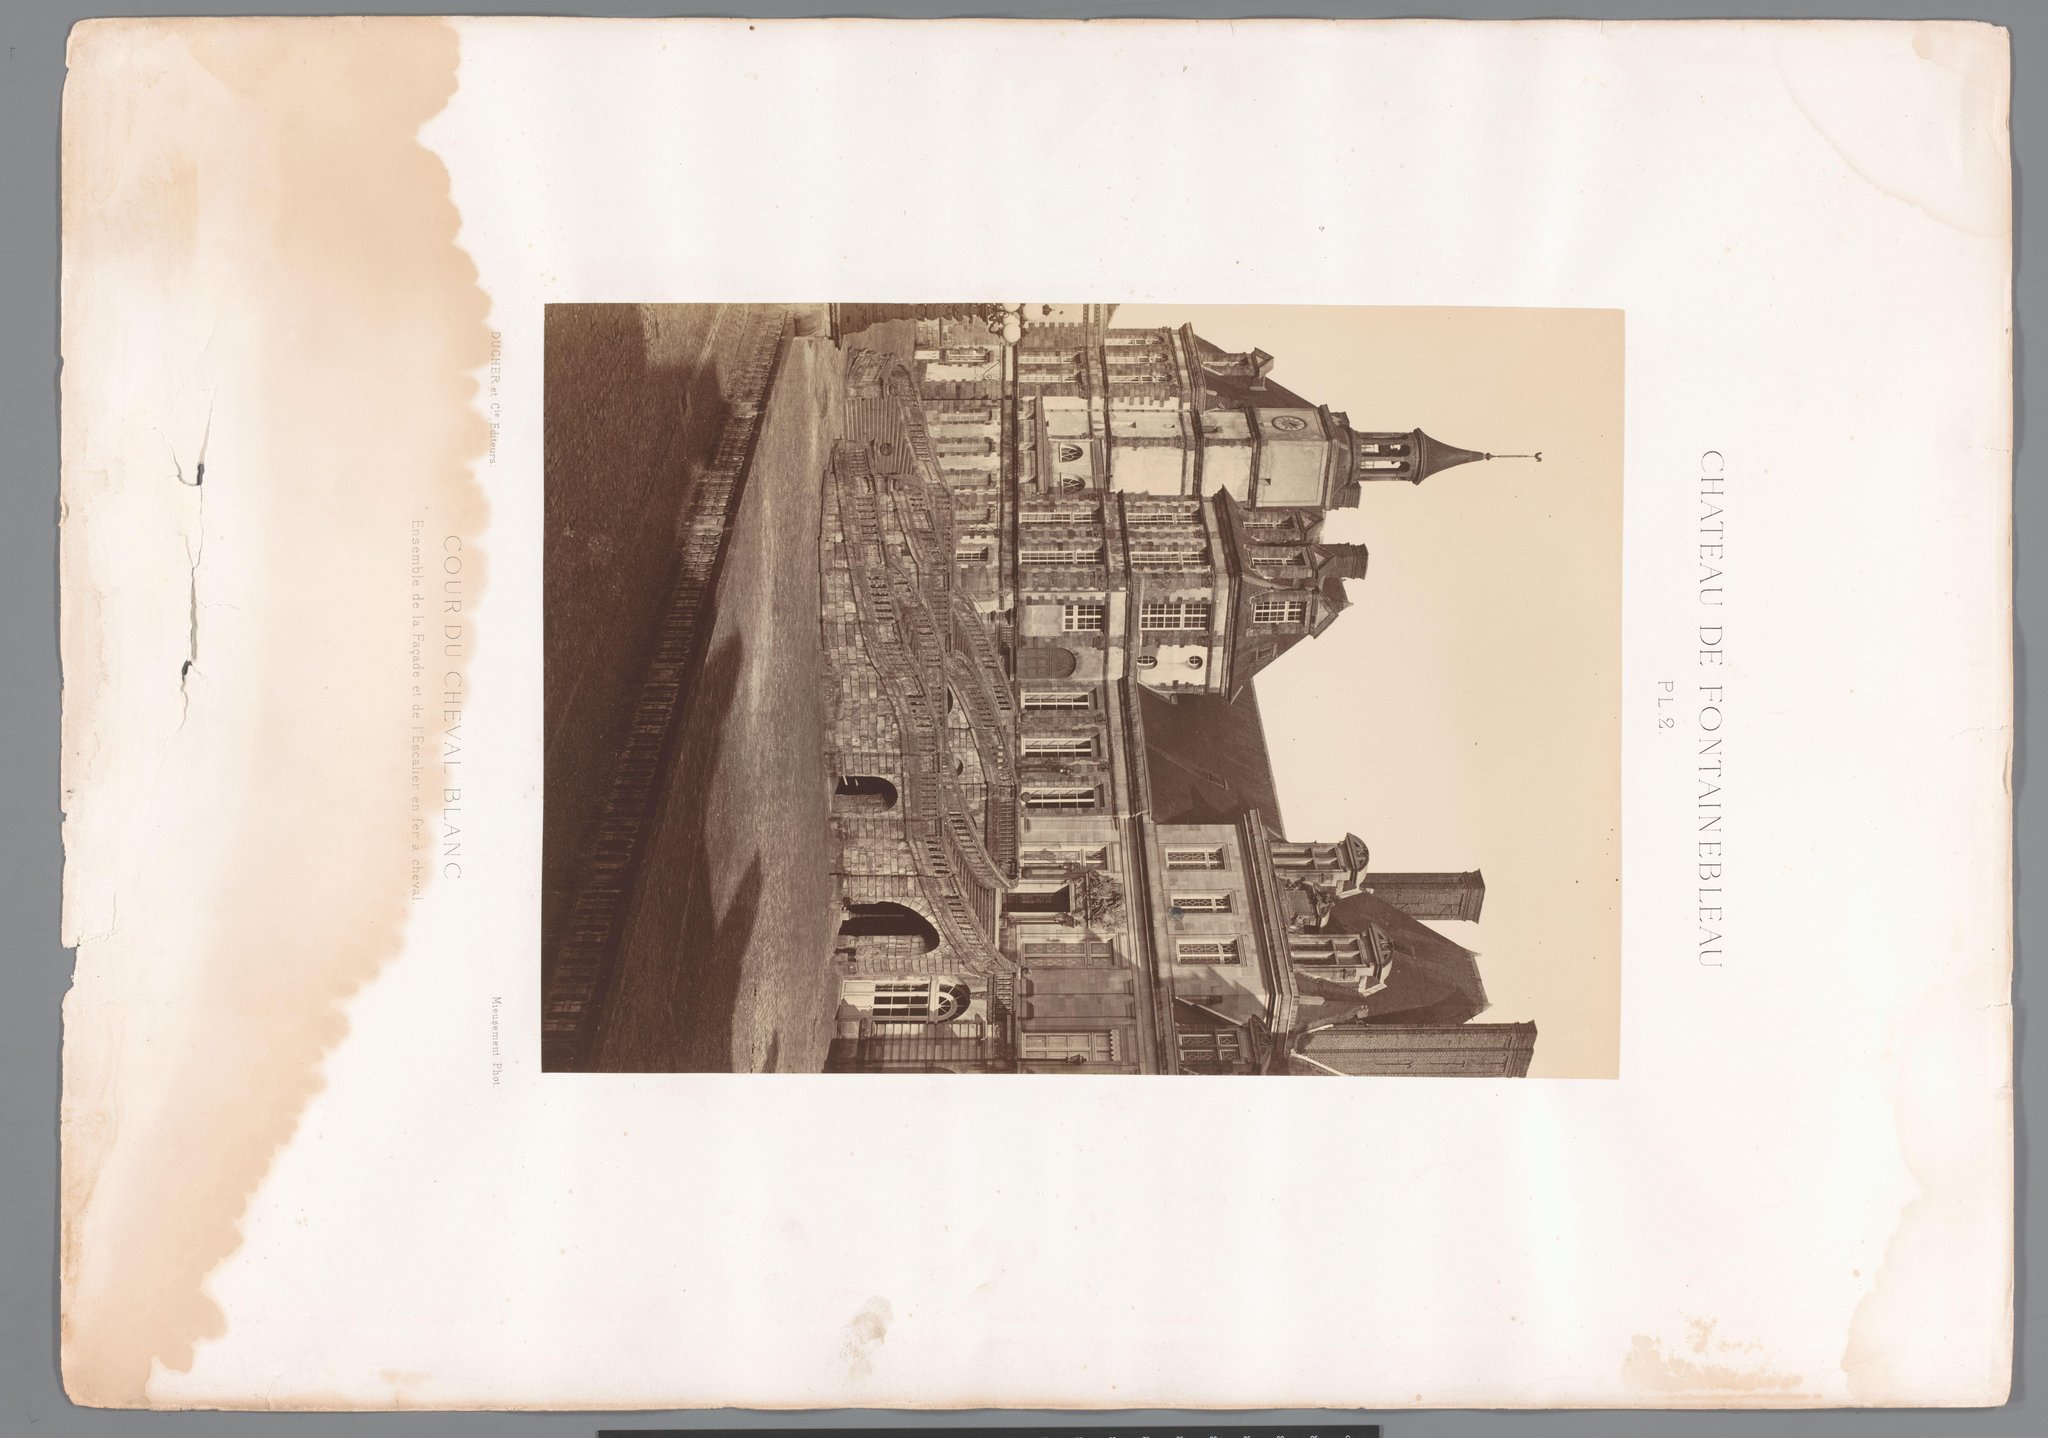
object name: photograph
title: Chateau de Fontainebleau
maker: séraphin-médéric mieusement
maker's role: fotograaf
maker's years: 1840-1905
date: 1870-1875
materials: photographic support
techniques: albumen print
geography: fontainebleau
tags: flight of steps, castle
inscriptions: number: ‘PL. 2.’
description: Deze foto maakt deel uit van een omslag met dertig foto's en twee tekstbladen.